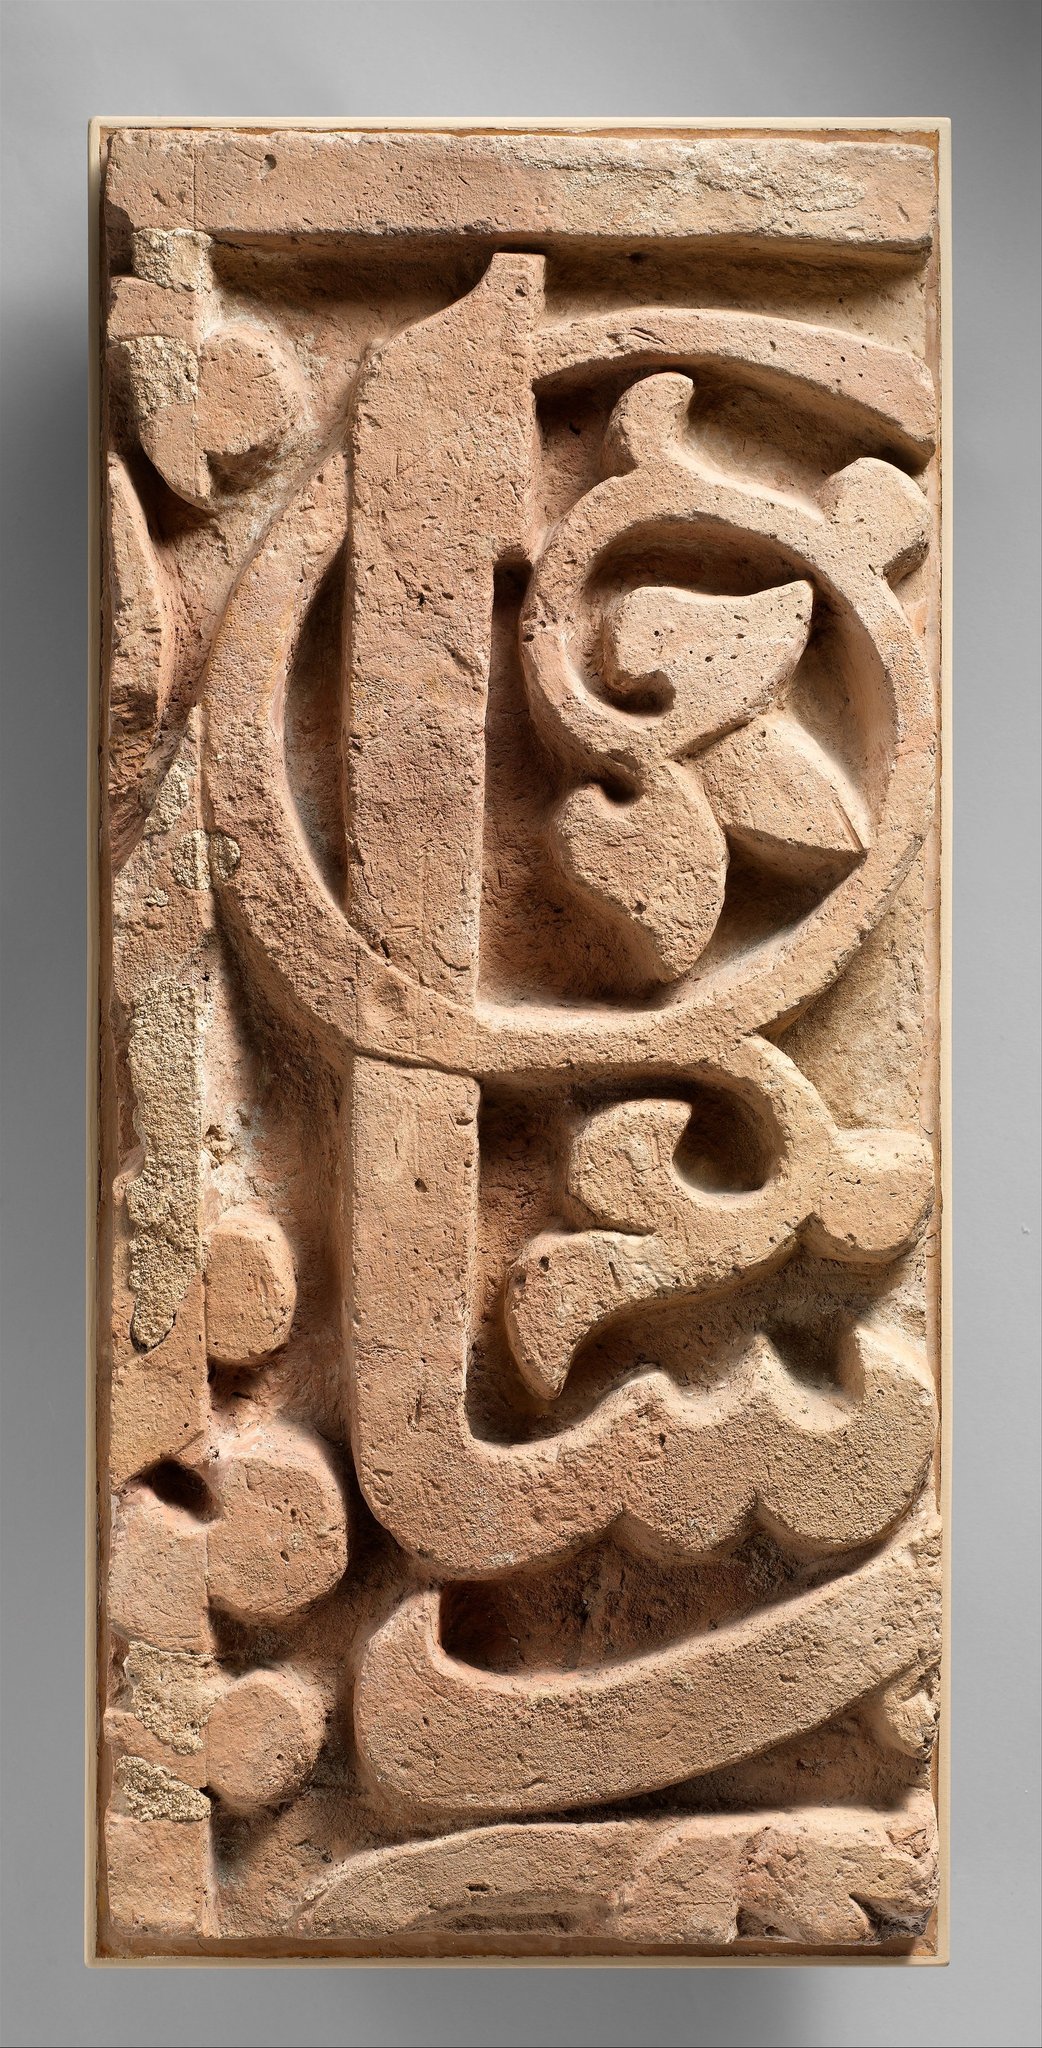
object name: frieze fragment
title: Panel from a Mosque Frieze Bearing the Name of a Sultan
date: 1001-1100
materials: terracotta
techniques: carving, painting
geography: iran